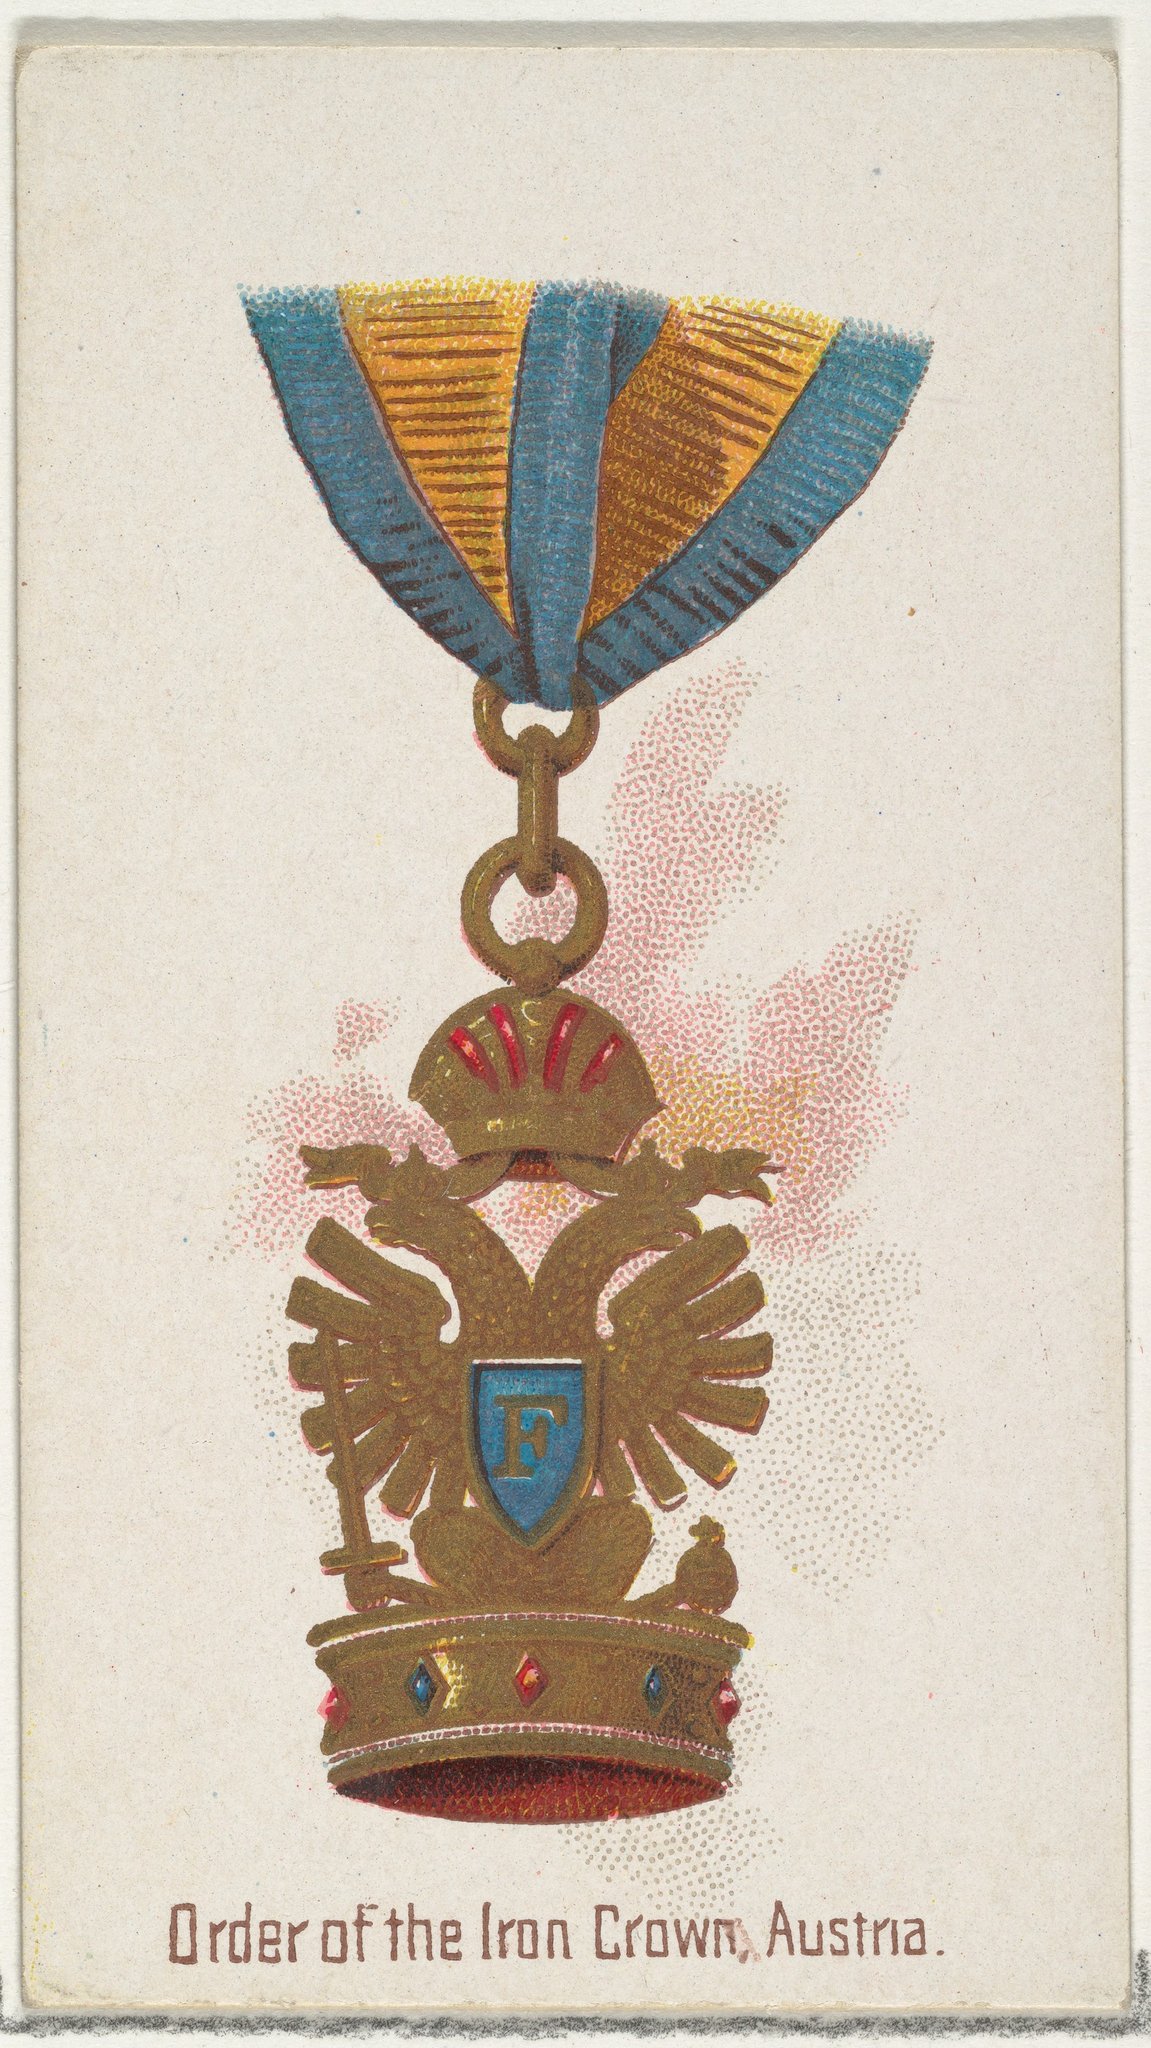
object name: print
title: Order of the Iron Crown, Austria, from the World's Decorations series (N30) for Allen & Ginter Cigarettes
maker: allen & ginter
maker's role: publisher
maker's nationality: american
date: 1890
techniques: color lithograph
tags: medals